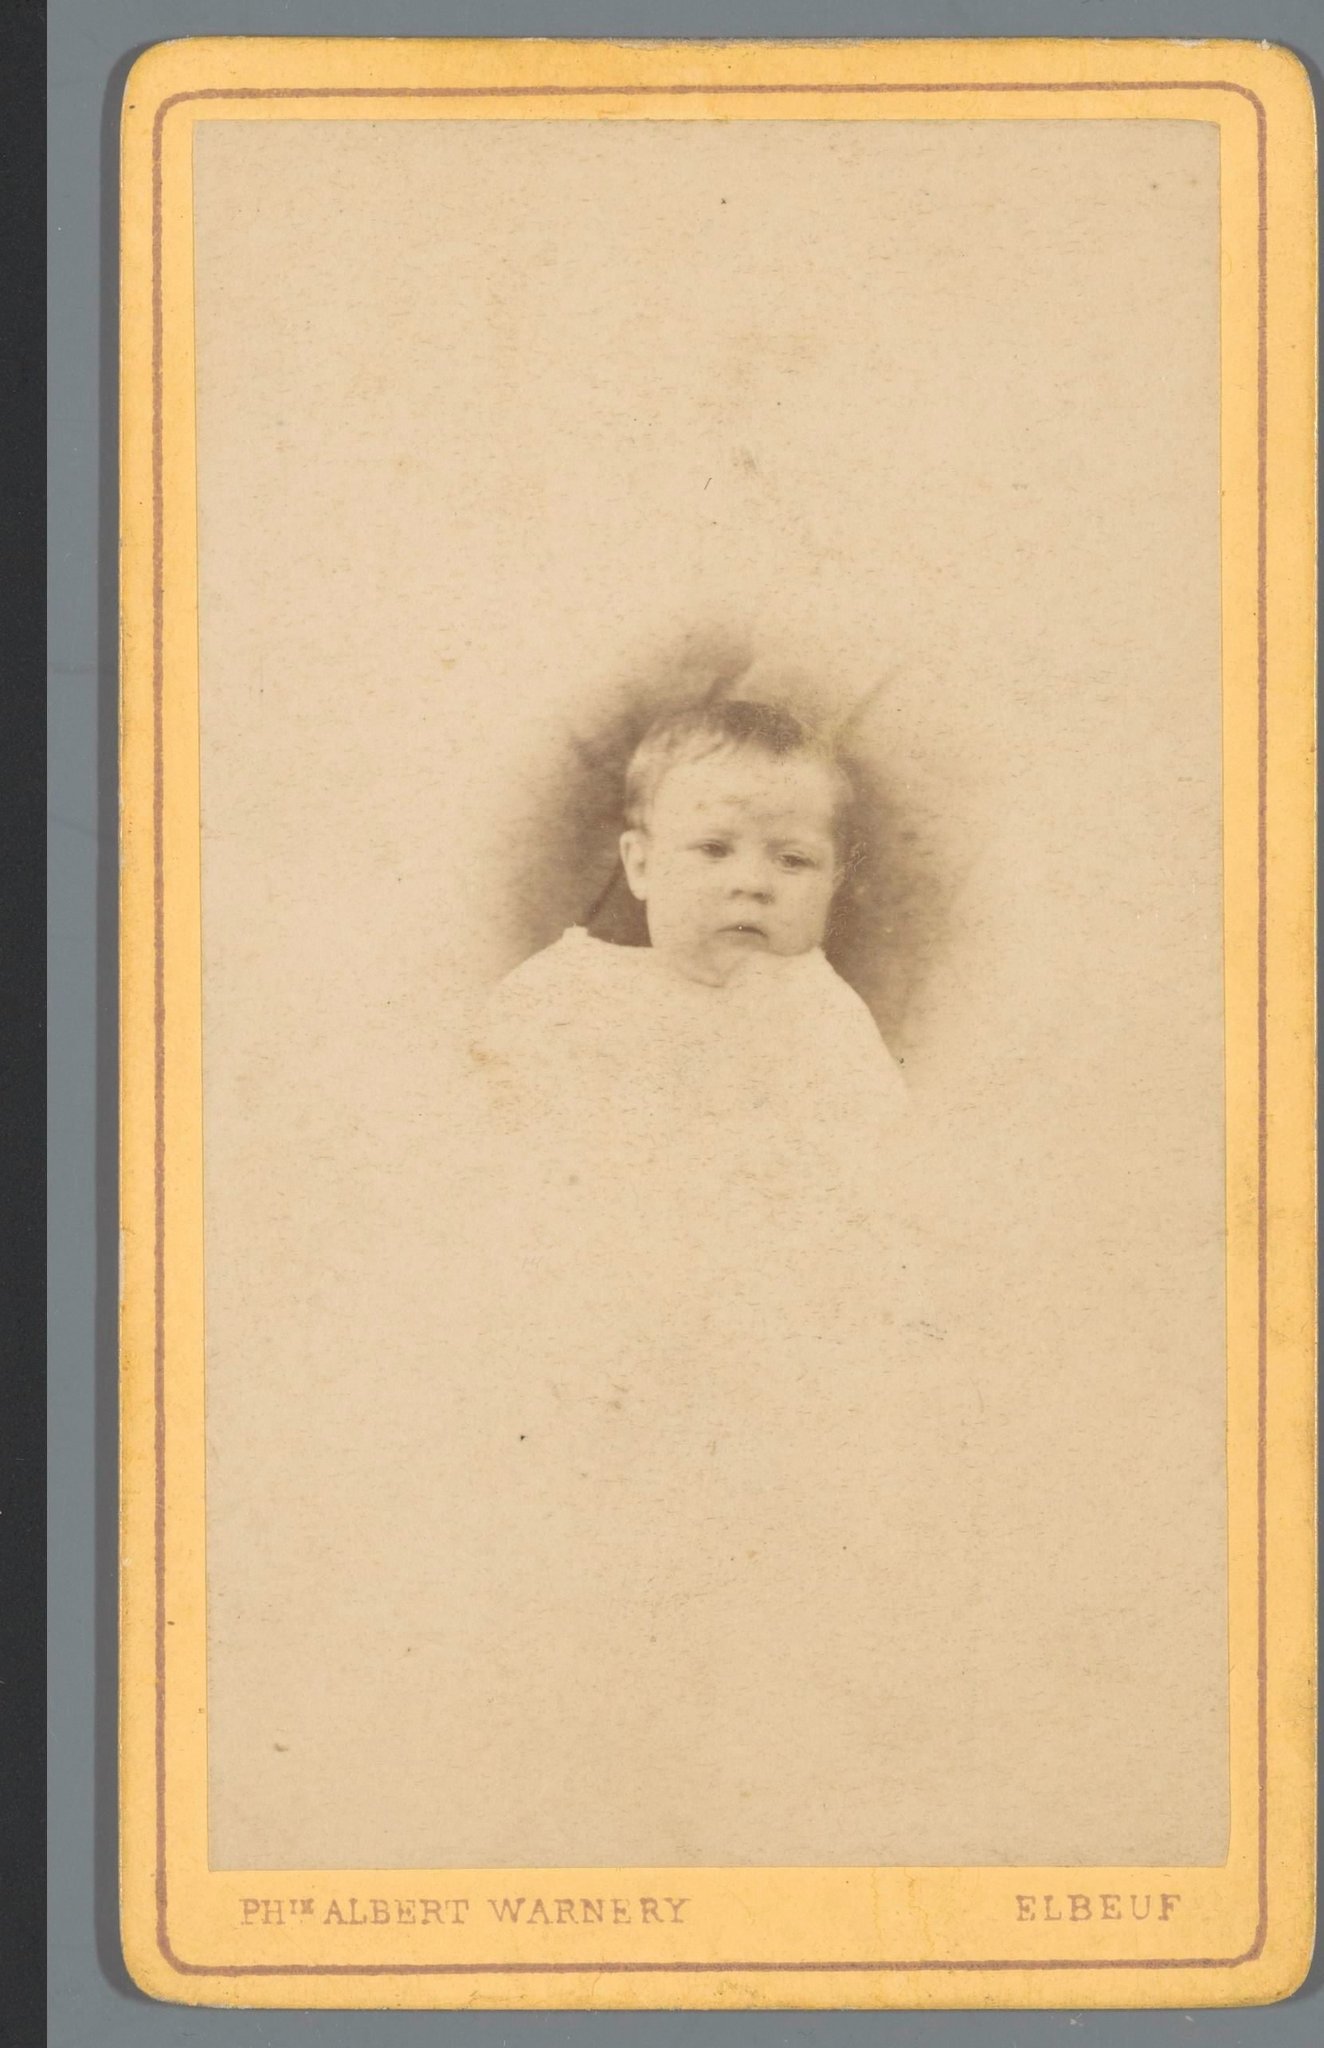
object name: carte de visite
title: Portret van een onbekende baby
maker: albert alfred warnery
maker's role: fotograaf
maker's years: 1853-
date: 1873-1885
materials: cardboard, paper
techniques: albumen print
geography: elbeuf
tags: anonymous historical person portrayed, infant, baby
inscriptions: address: ‘8, Rue St Auct, 8/ ELBEUF’